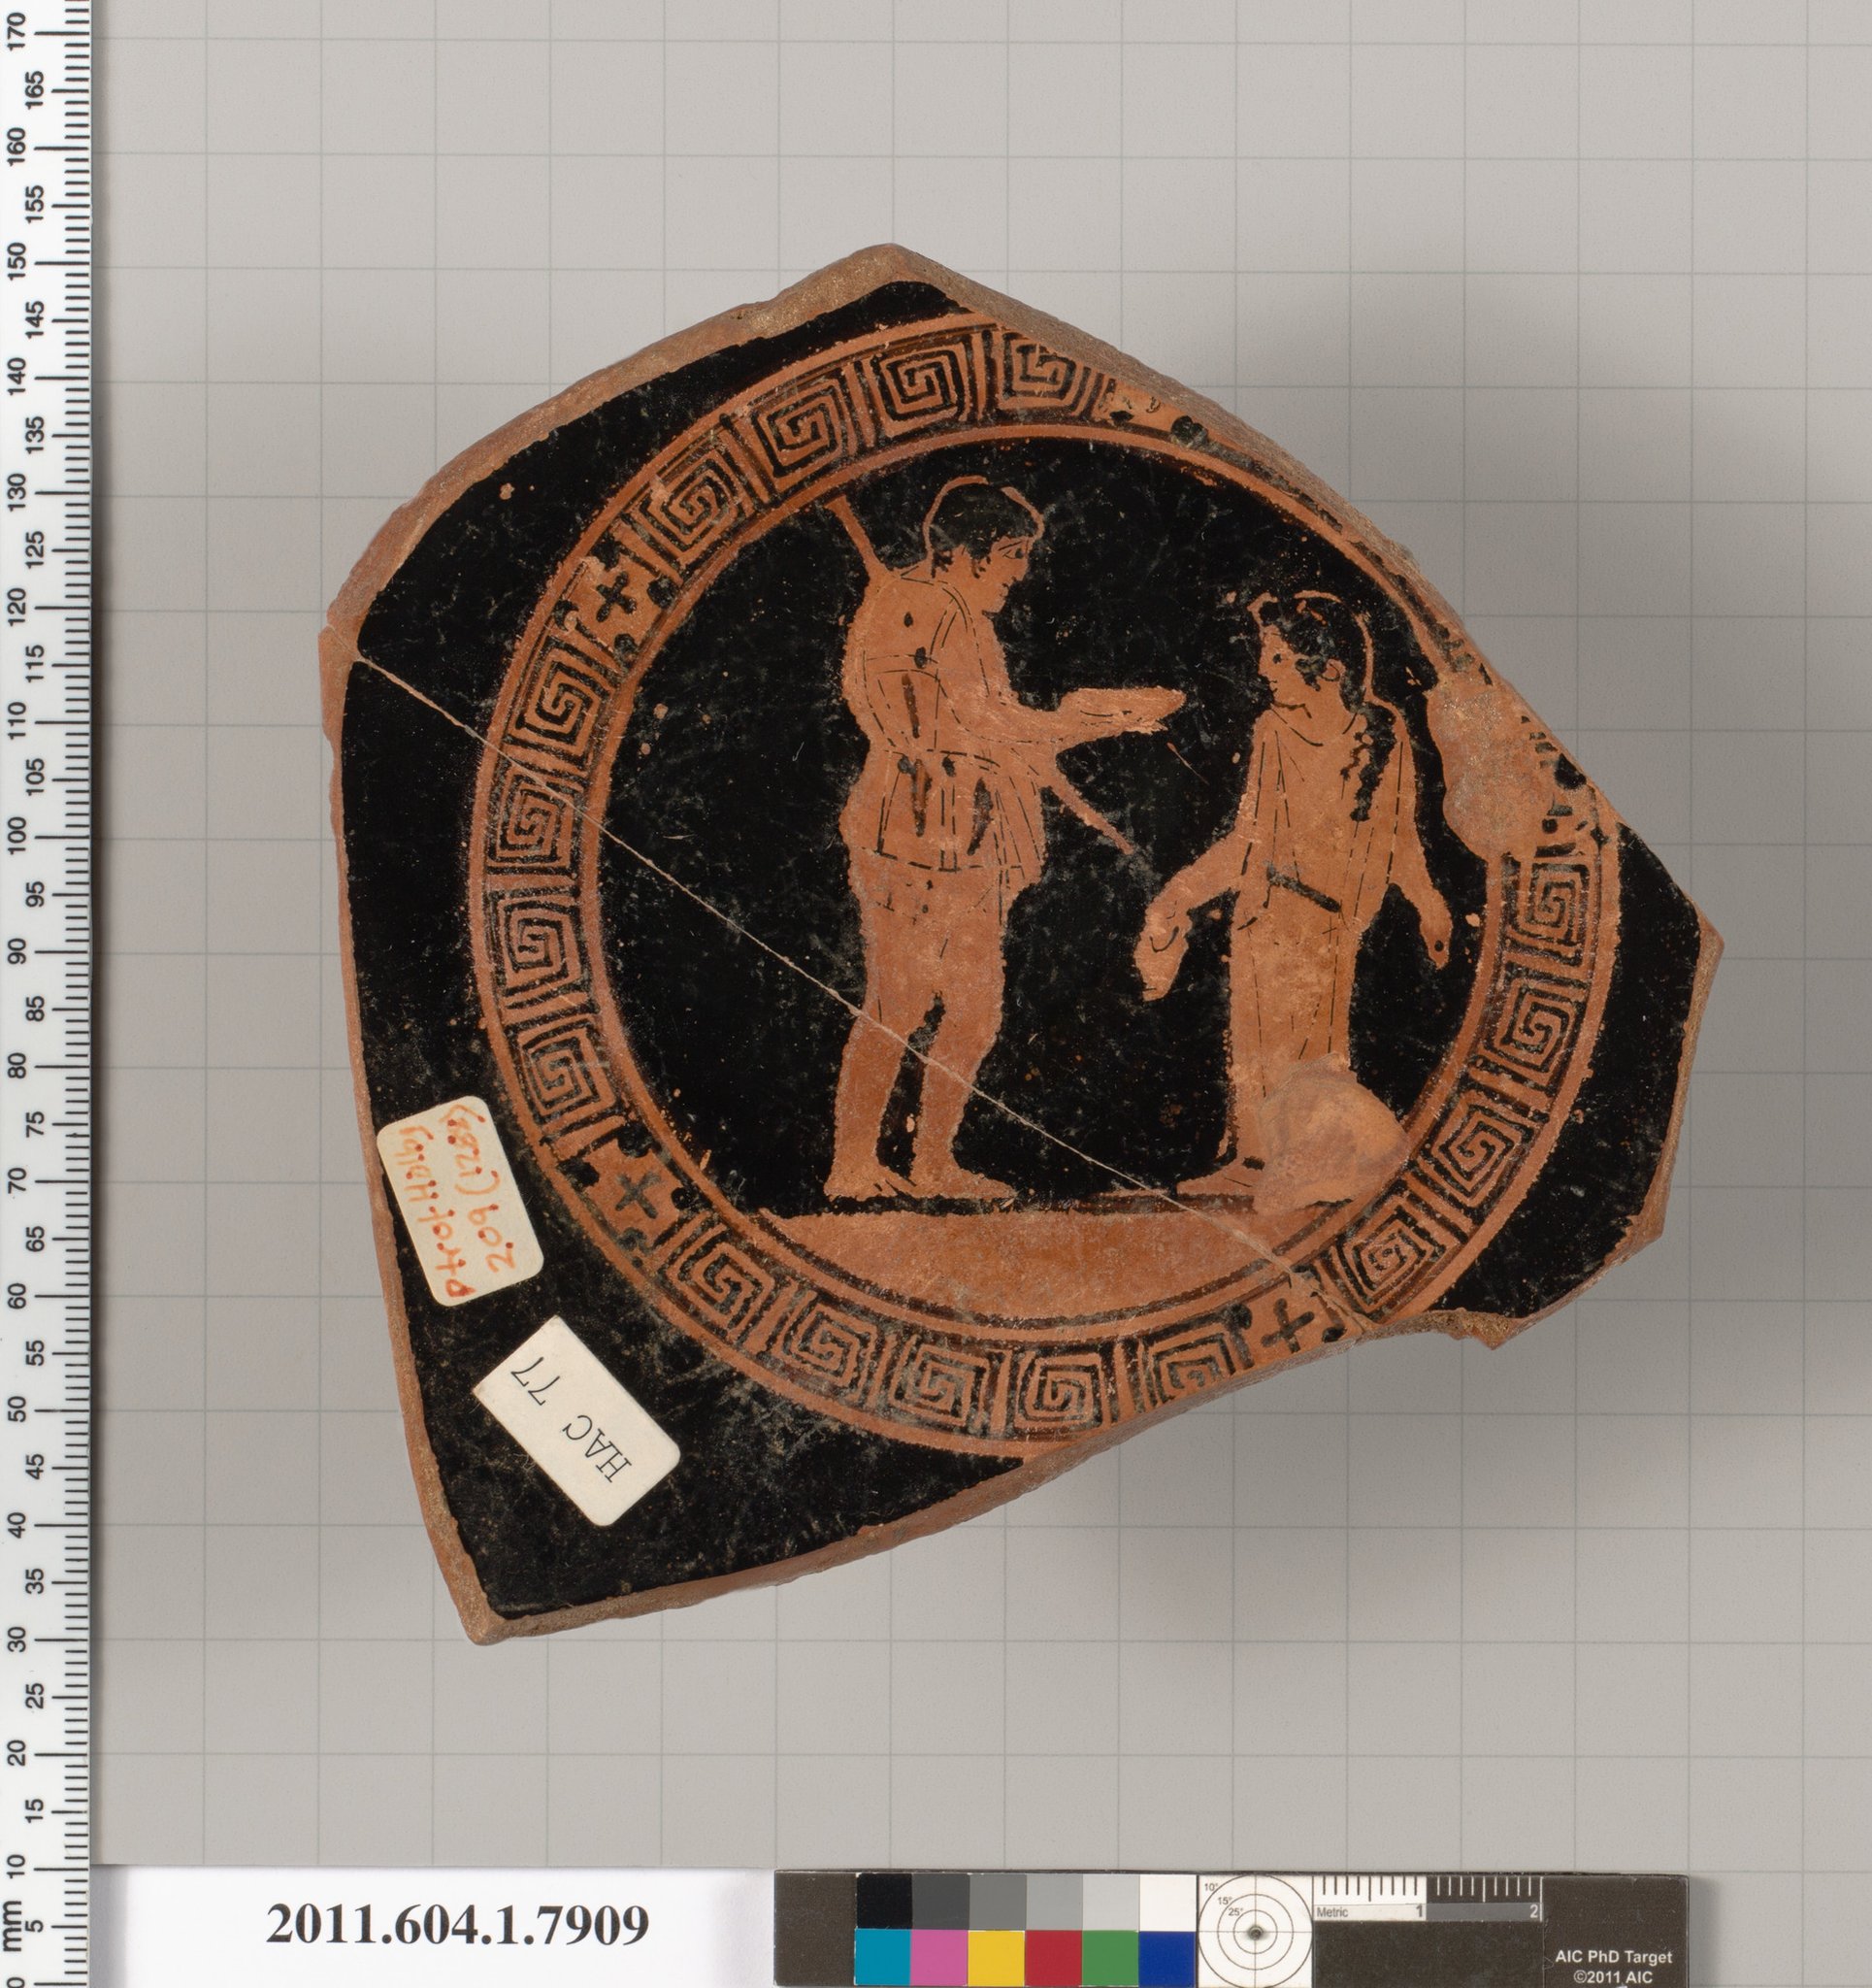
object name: kylix fragment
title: Terracotta fragment of a kylix (drinking cup)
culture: greek, attic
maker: painter of heidelberg 209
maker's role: artist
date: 450-426 BCE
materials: terracotta